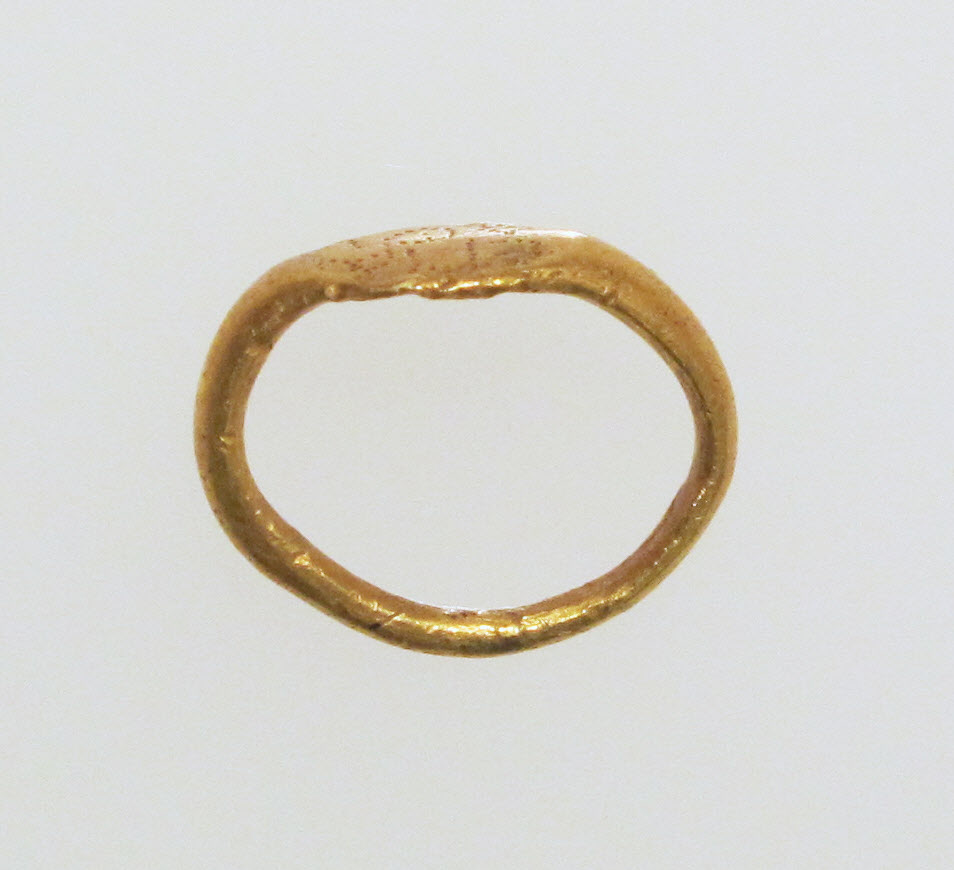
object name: ring, motto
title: Gold ring with inscribed bezel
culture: roman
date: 100 BCE-300 CE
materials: gold